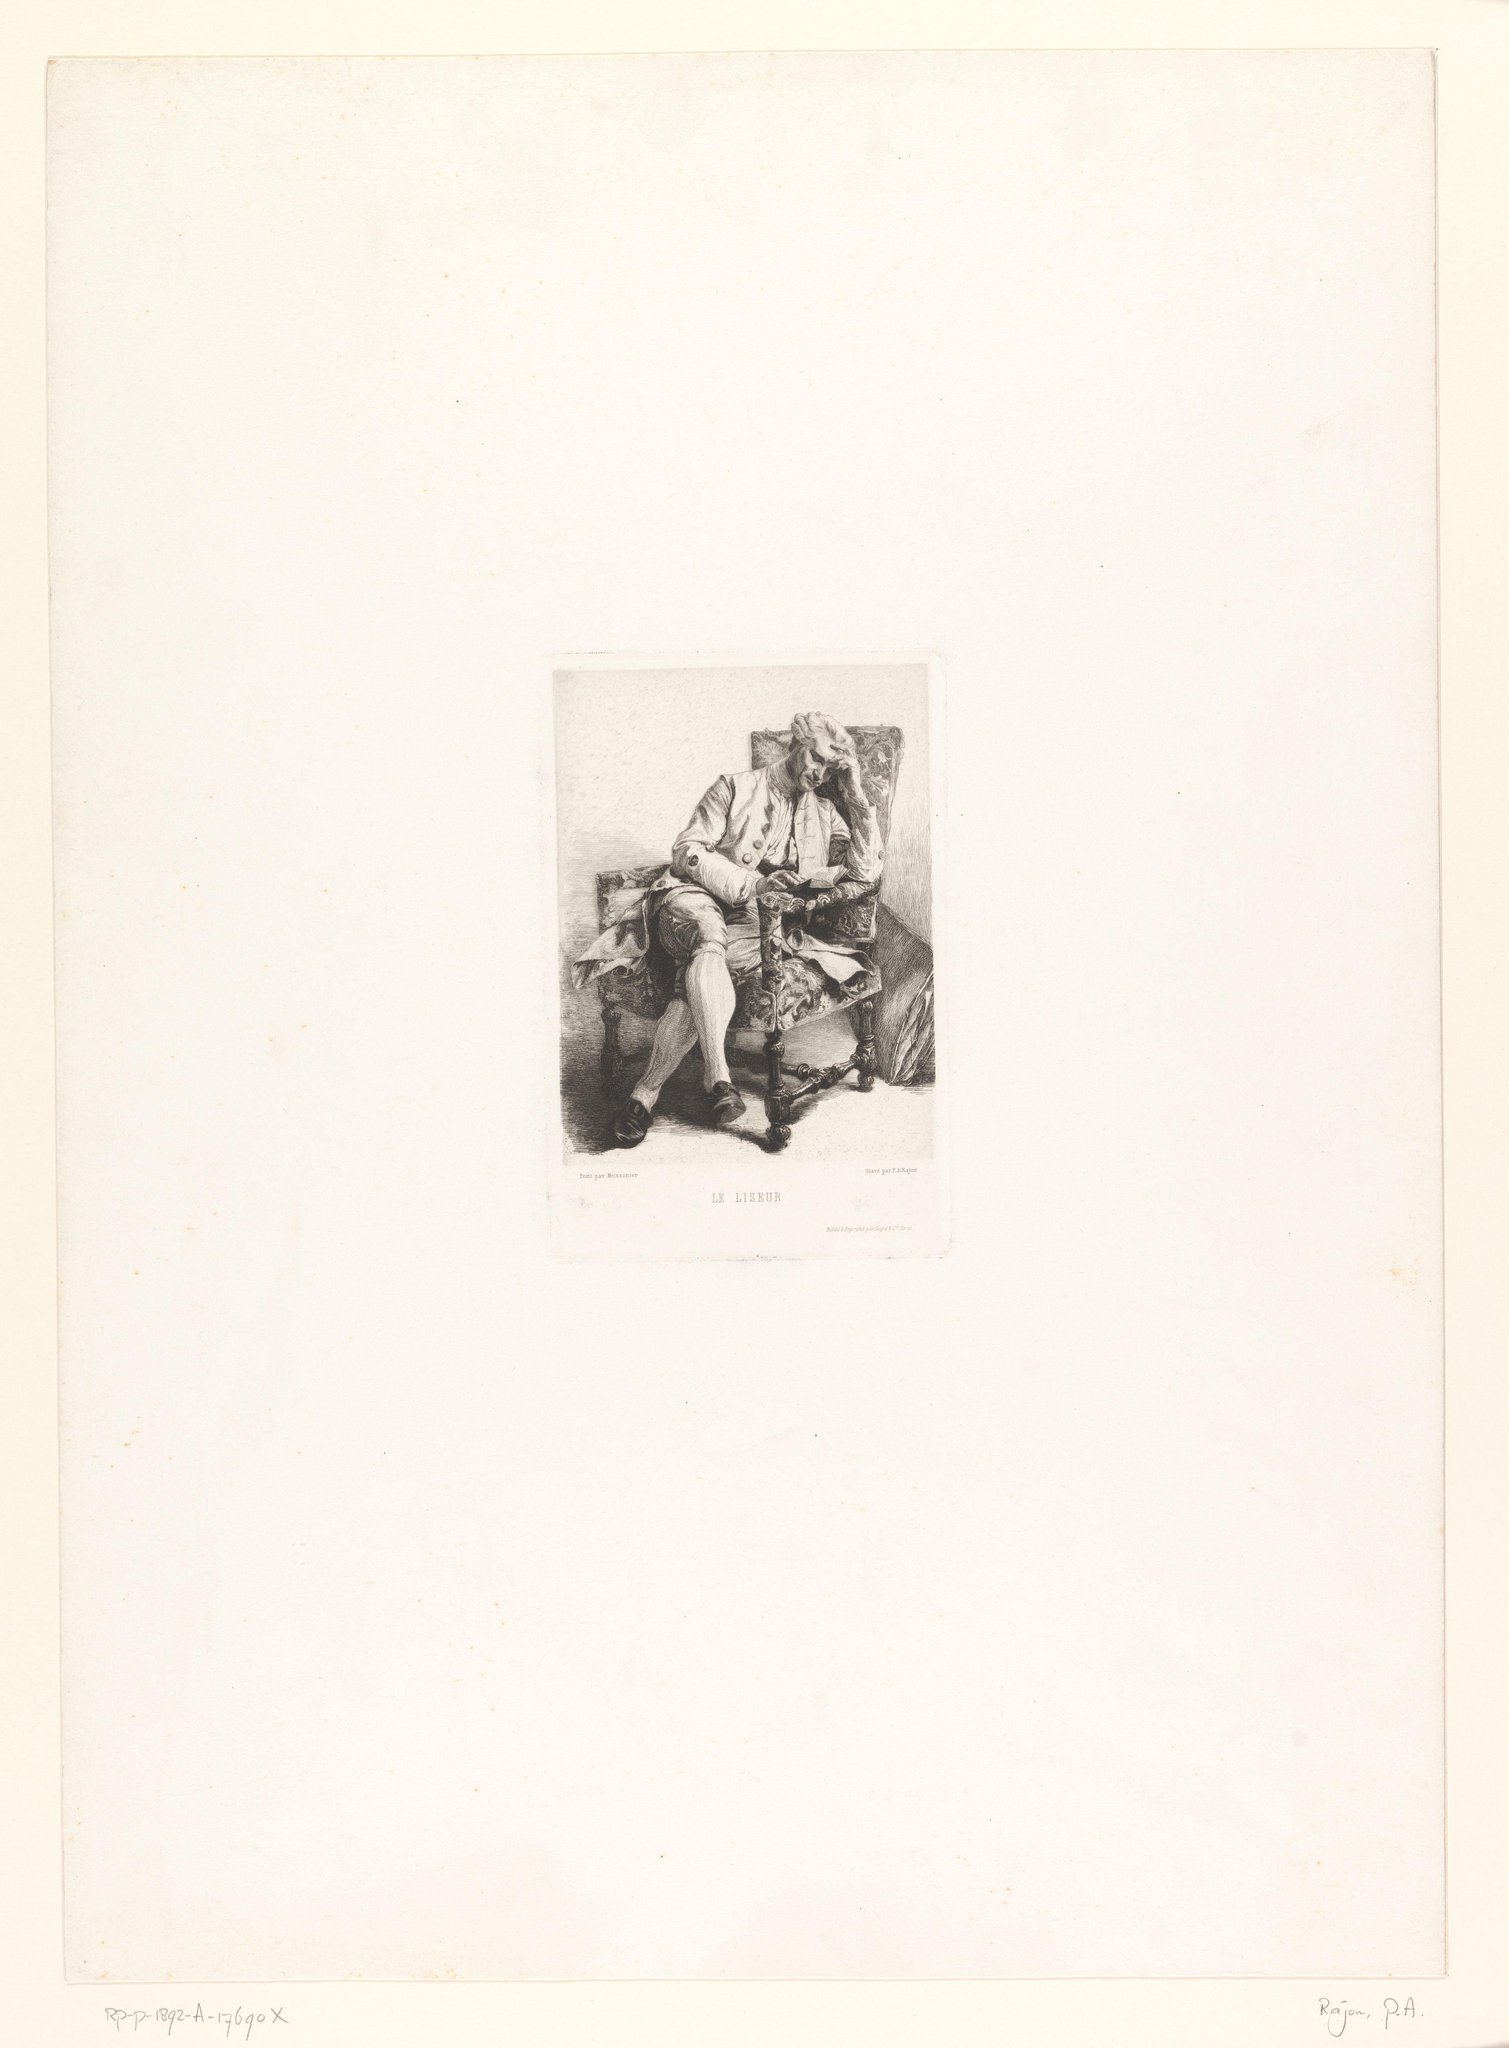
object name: print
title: Le liseur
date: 1868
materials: paper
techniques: etching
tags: reading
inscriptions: collector's mark: Lugt 2228